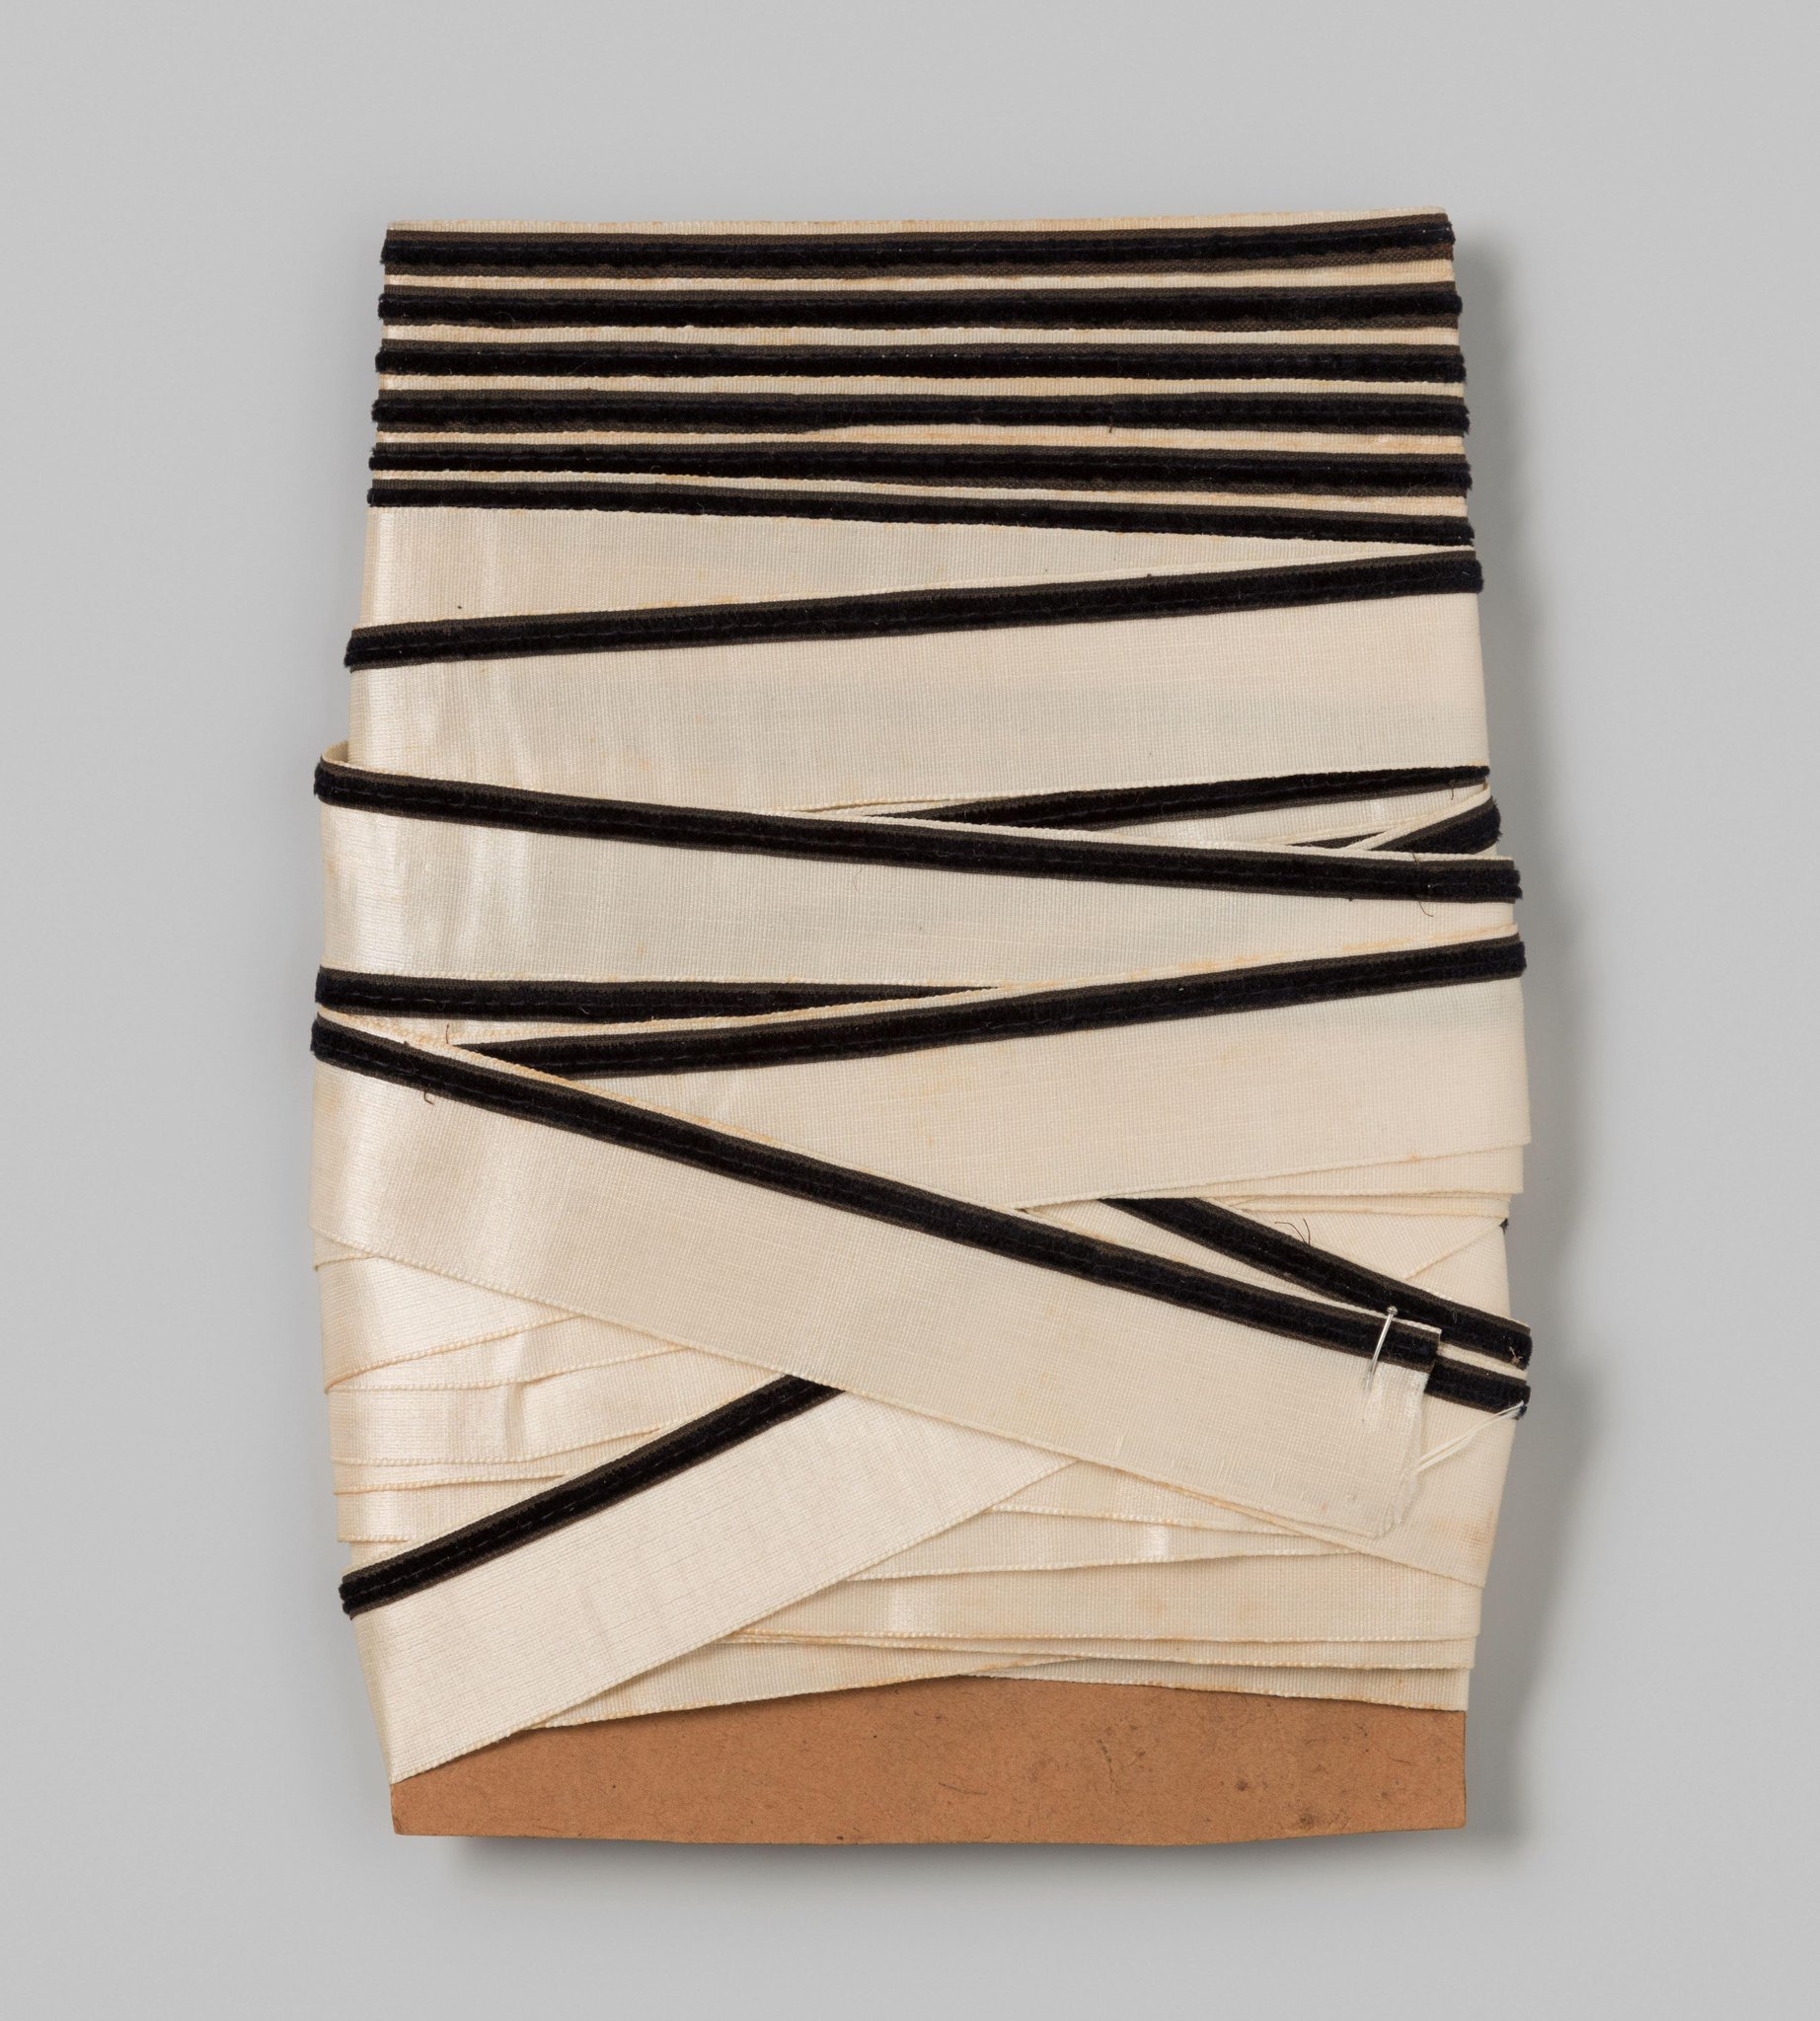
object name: ribbon material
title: Lint op karton, wit satijnlint met daarop een smal zwart fluwelen lint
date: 1926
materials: cardboard, textile, velvet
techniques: weave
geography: nijmegen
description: Lint op karton, wit satijnlint met daarop een smal zwart fluwelen lint.